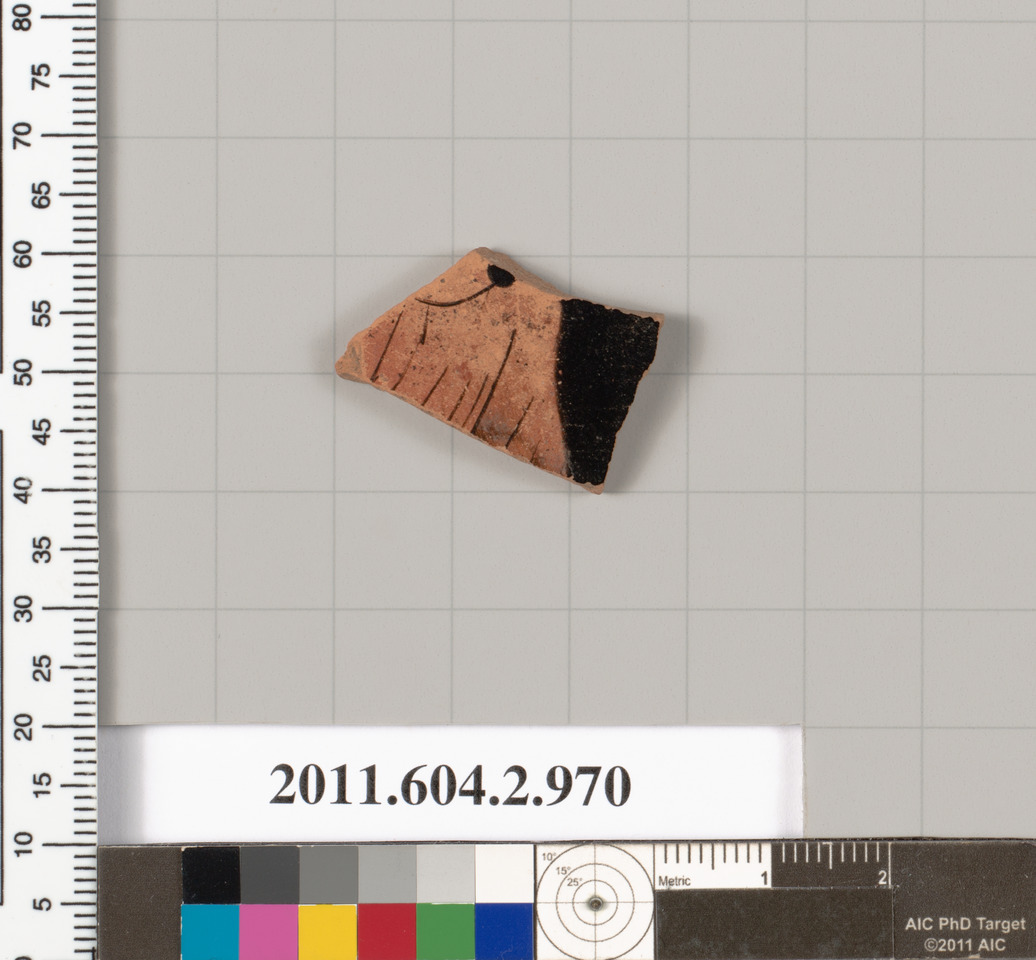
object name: oinochoe fragment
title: Terracotta fragment of an oinochoe (jug)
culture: greek, attic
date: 460-440 BCE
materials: terracotta